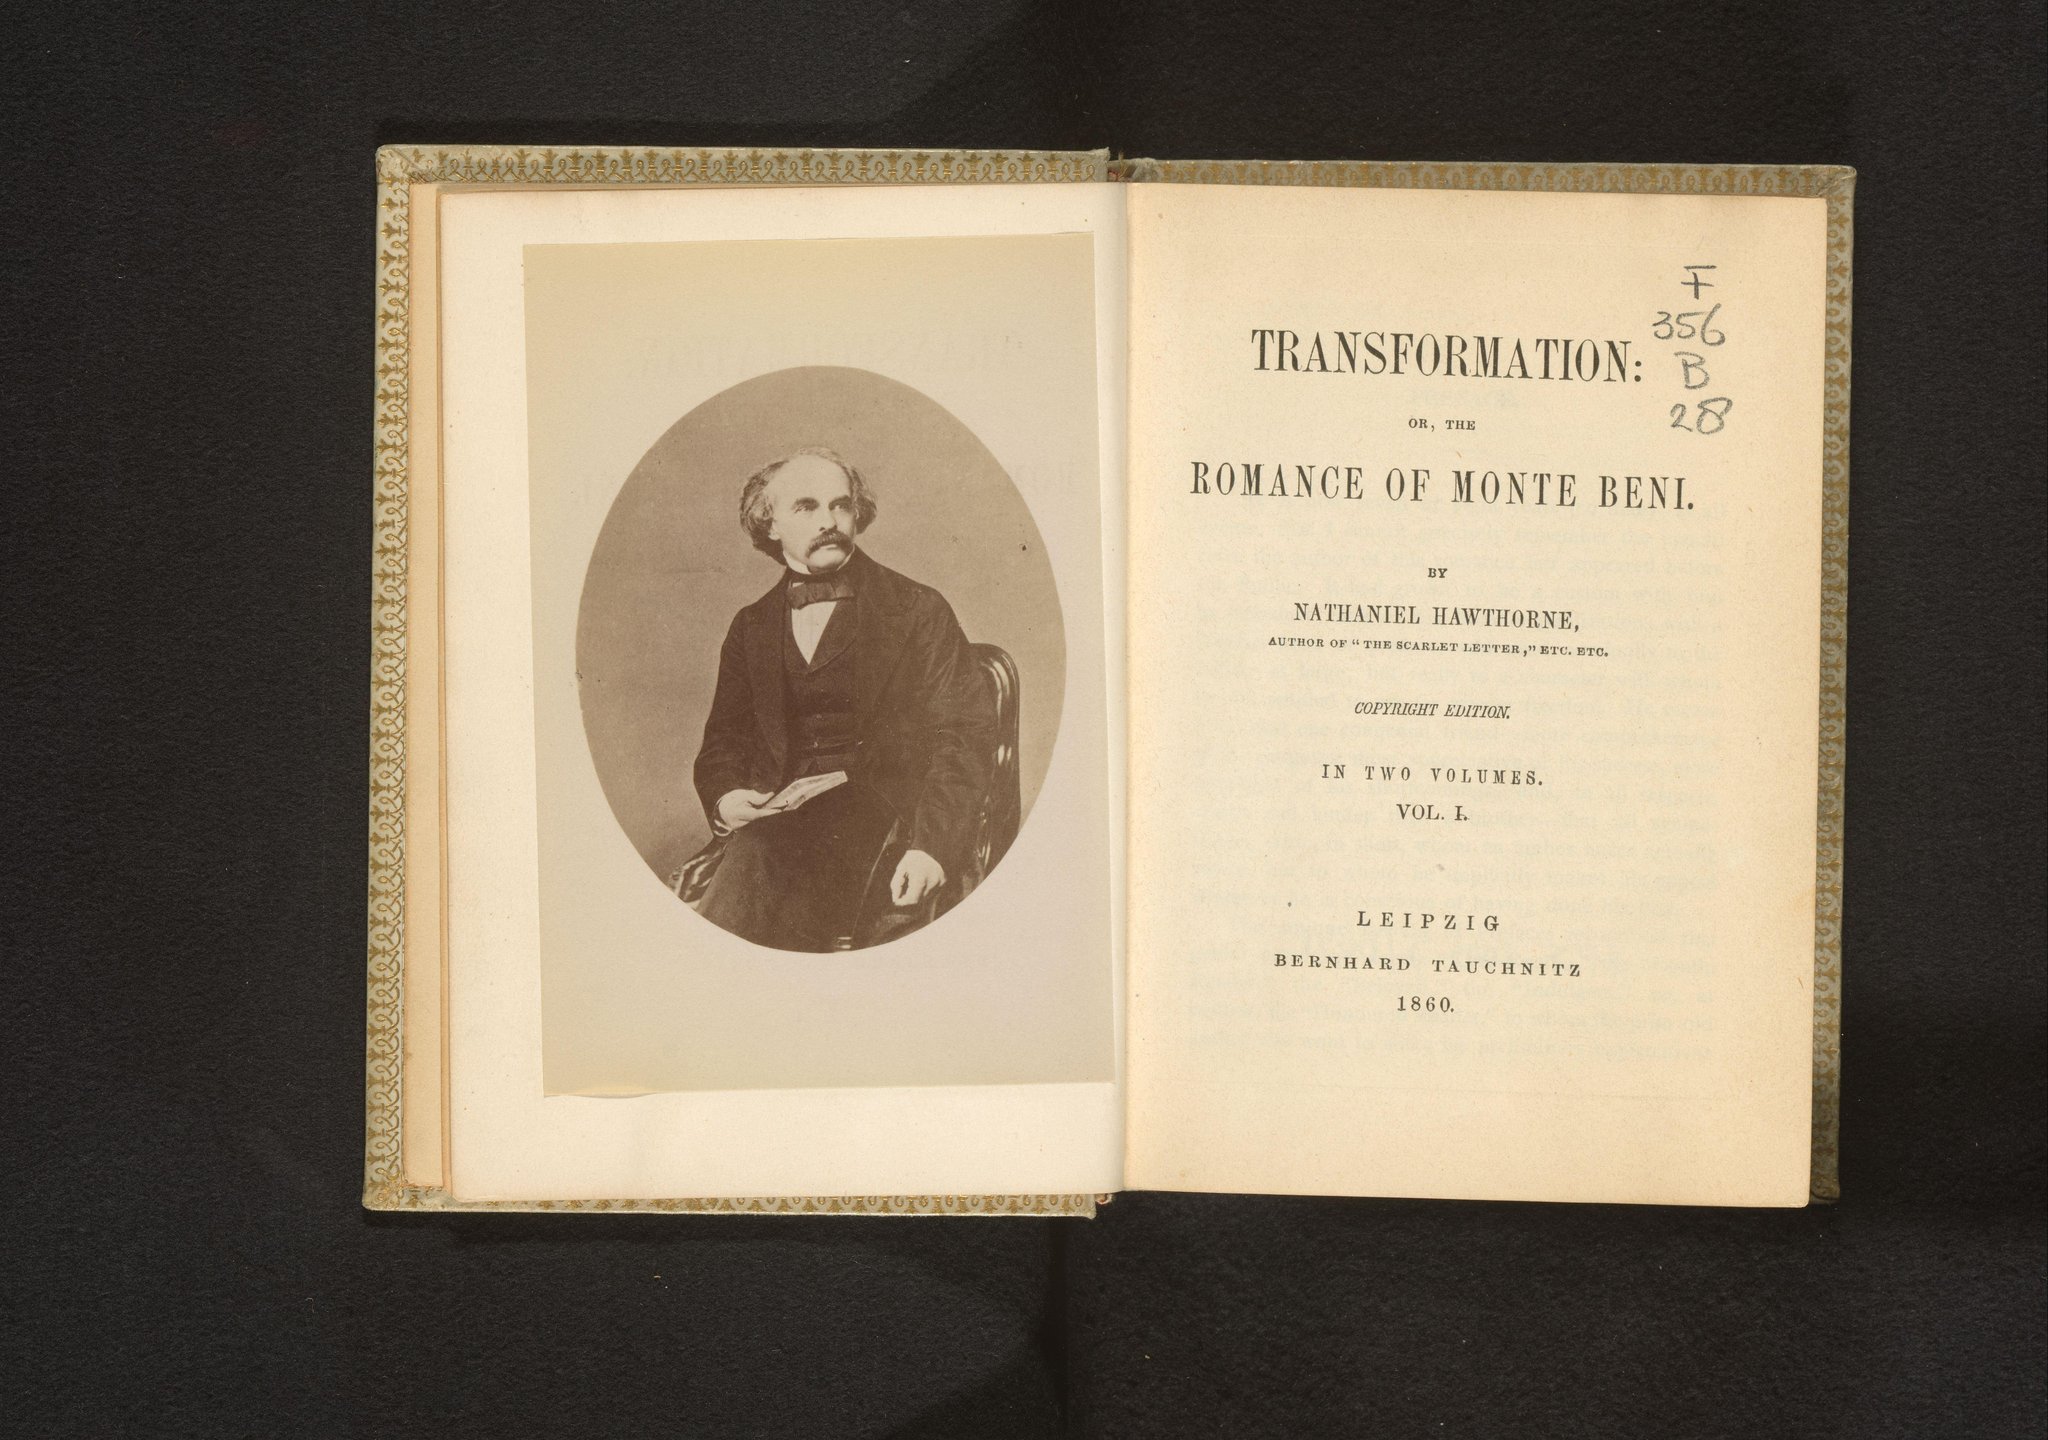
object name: book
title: Transformation : or, the romance of Monte Beni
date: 1860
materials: cardboard, paper, photographic support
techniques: albumen print, decorated paper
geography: leipzig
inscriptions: inscription: ‘Alice Roberts Preston.’, name: ‘ex libris SFJ’